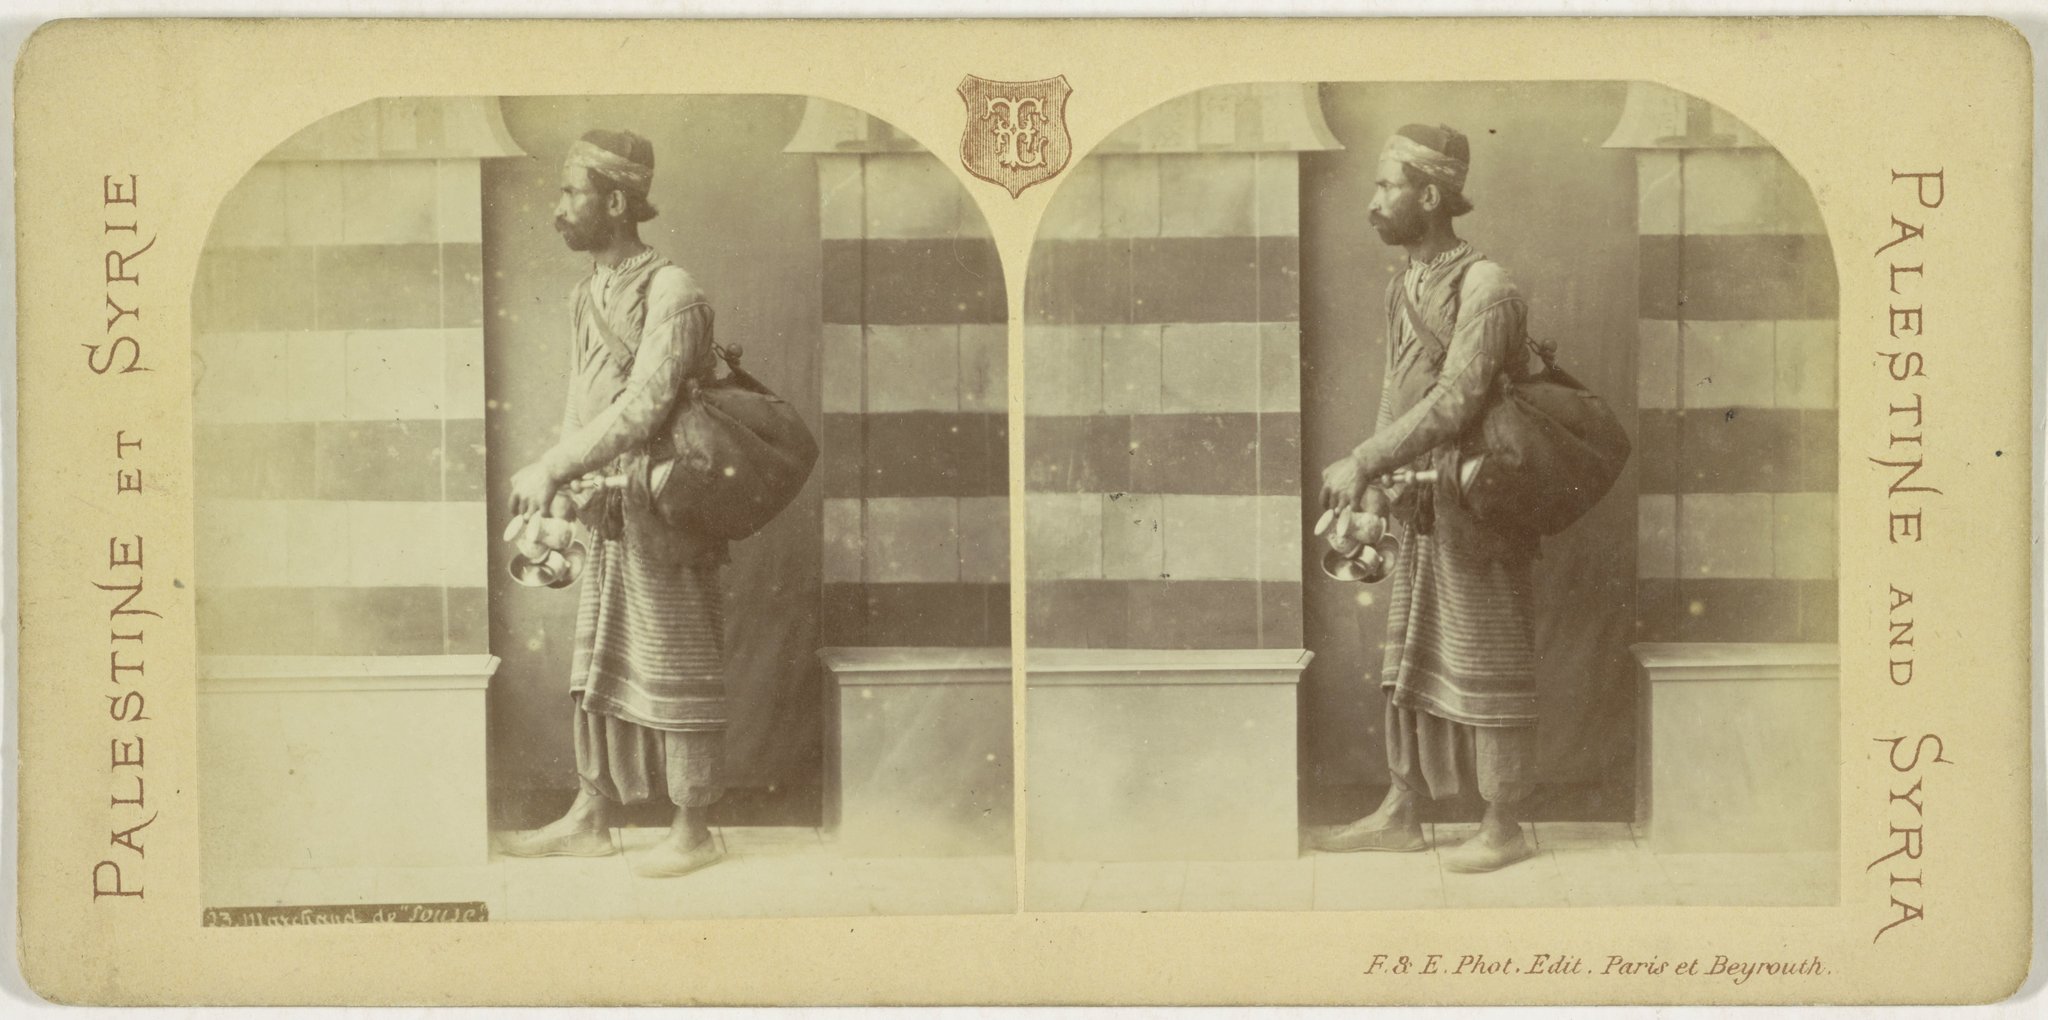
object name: stereograph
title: Koopman te Sousse, Tunesië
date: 1879-1910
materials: cardboard, paper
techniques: albumen print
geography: sousse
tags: merchant, salesman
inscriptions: number: ‘23.’